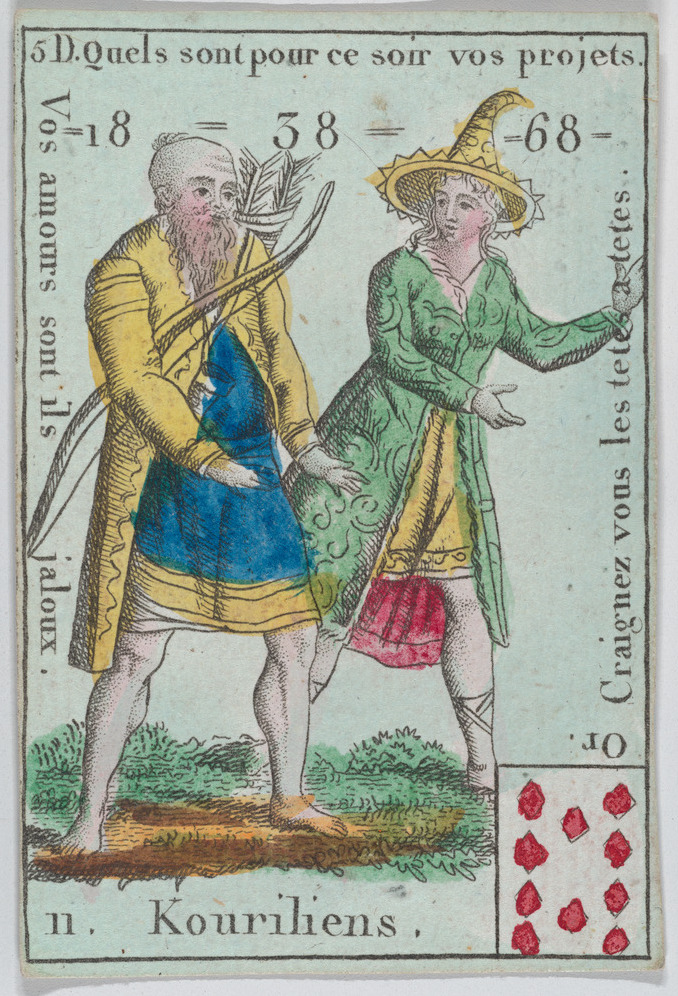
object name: print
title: Kouriliens from playing cards "Jeu d'Or"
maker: anonymous, french, 18th century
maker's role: artist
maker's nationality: french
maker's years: 1700-1800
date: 1700-1799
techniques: etching, hand coloring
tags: men,women,playing cards